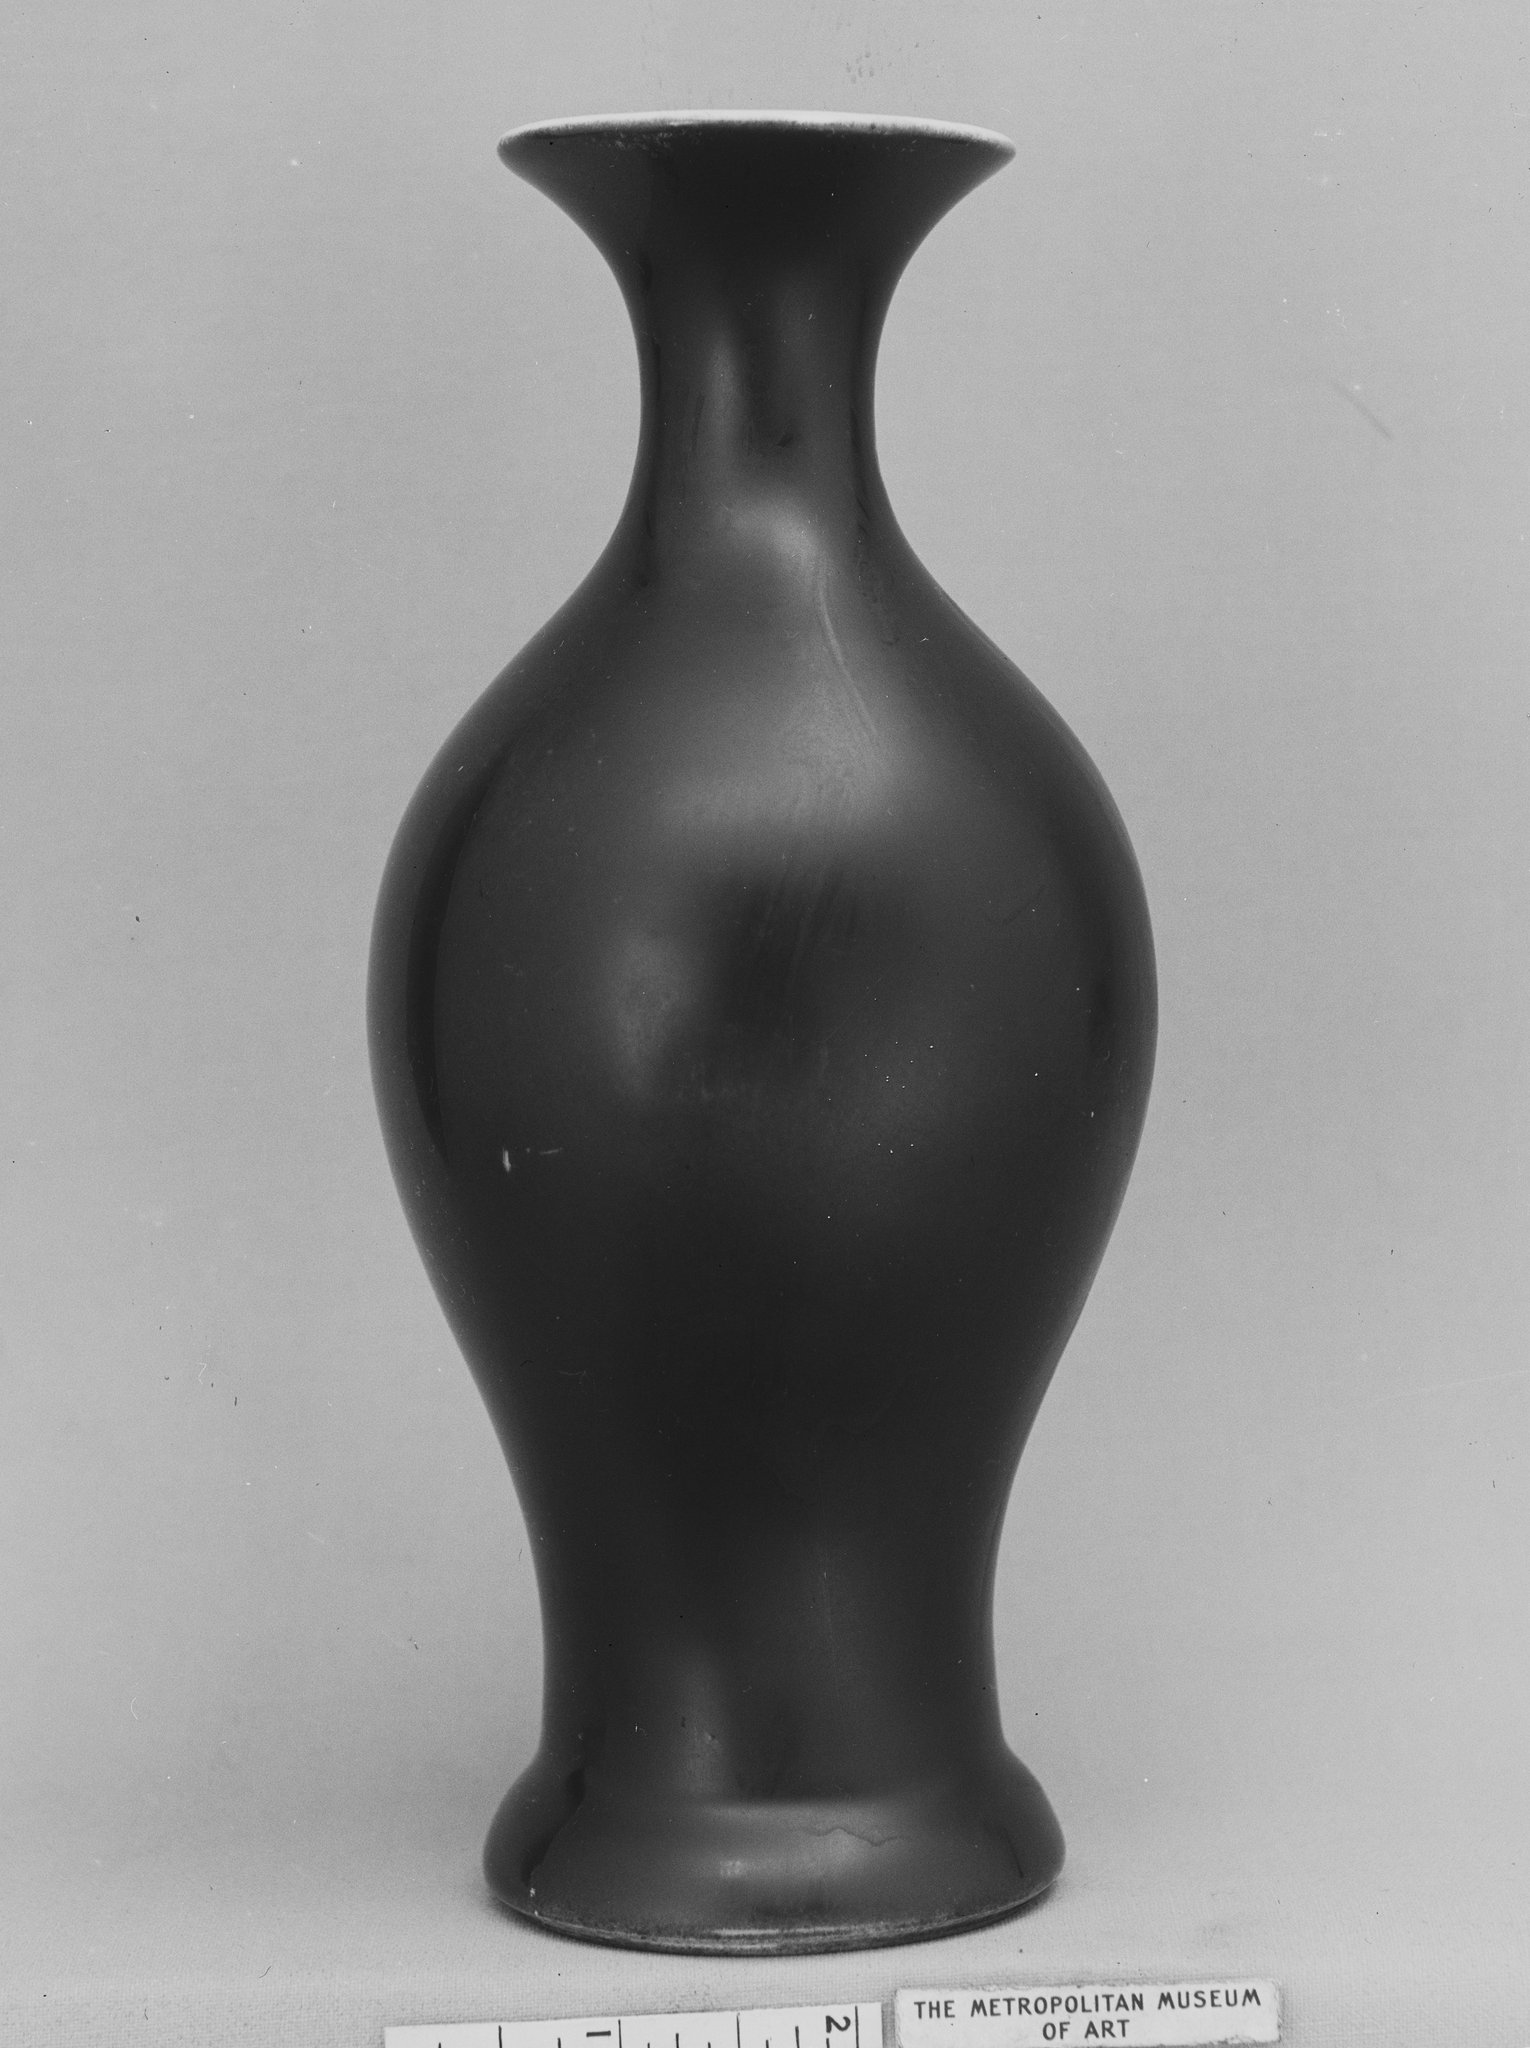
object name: vase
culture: chinese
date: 1767-1833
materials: coral, glaze, porcelain